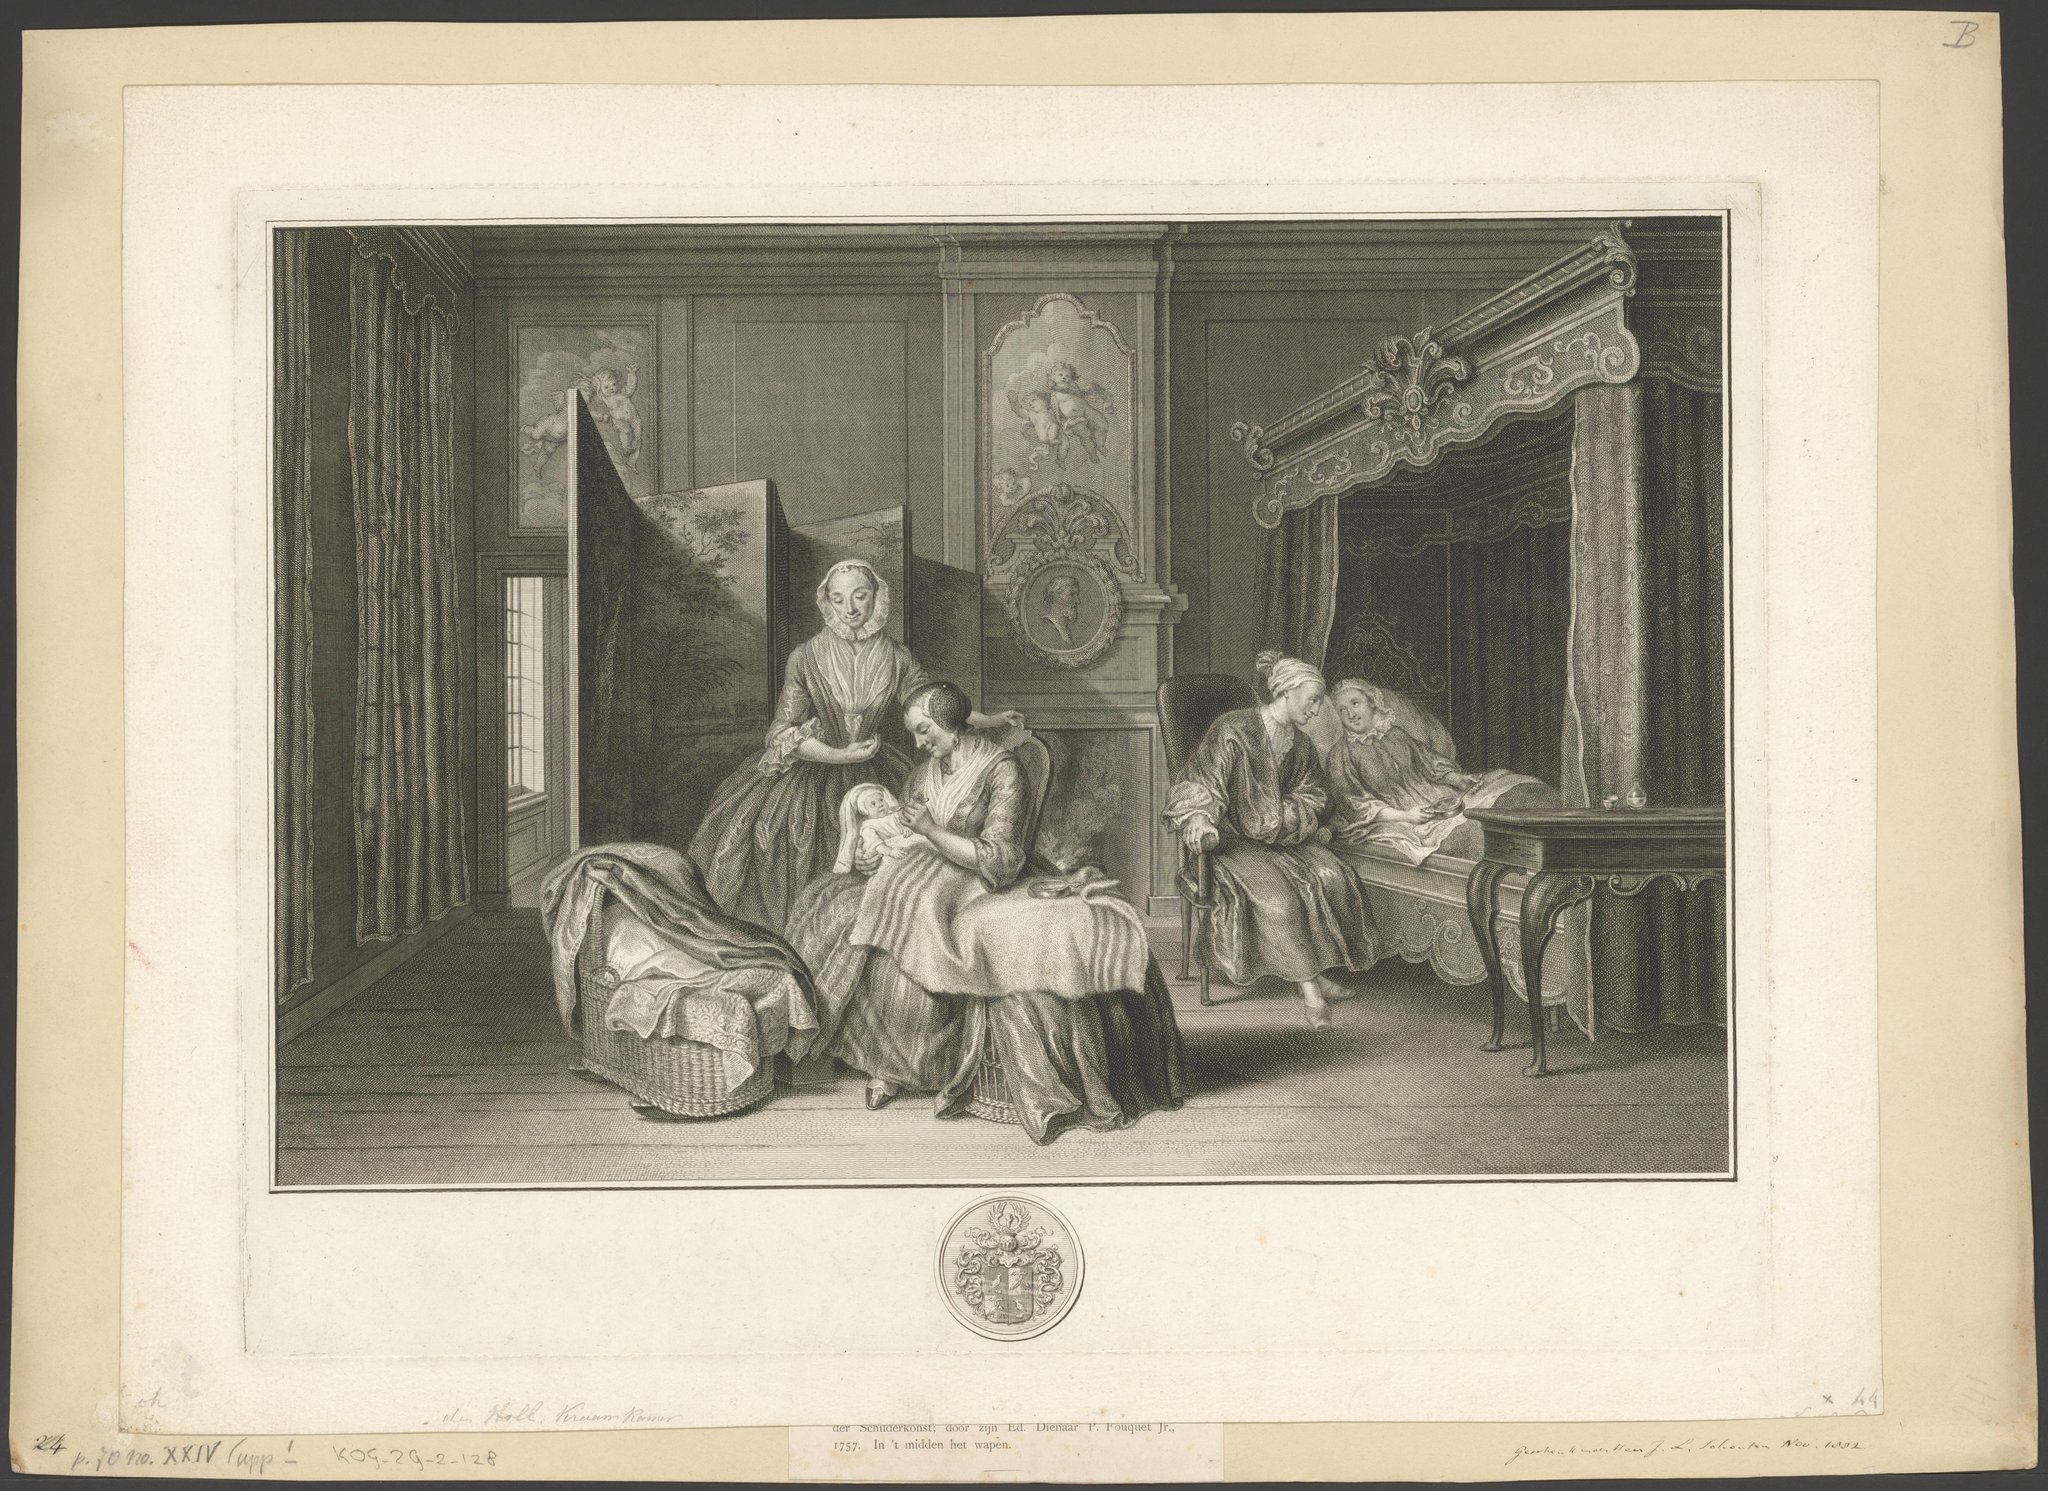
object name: print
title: Hollandse kraamkamer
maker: pieter tanjé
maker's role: draughtsman, print maker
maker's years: 1706-1761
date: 1757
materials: paper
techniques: engraving, etching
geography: amsterdam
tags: bed with tester, cradle, crib, family life at home, lying-in room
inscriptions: collector's mark: Lugt 2488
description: In de kraamkamer geeft een min de baby te eten, terwijl een andere vrouw toekijkt. Rechts ligt de moeder in een hemelbed. Naast haar zit haar man. Onderaan in de marge het wapenschild van Johann Goll van Frankenstein, die het originele schilderij in bezit had en aan wie de prent is opgedragen. Staat vóór de letter.